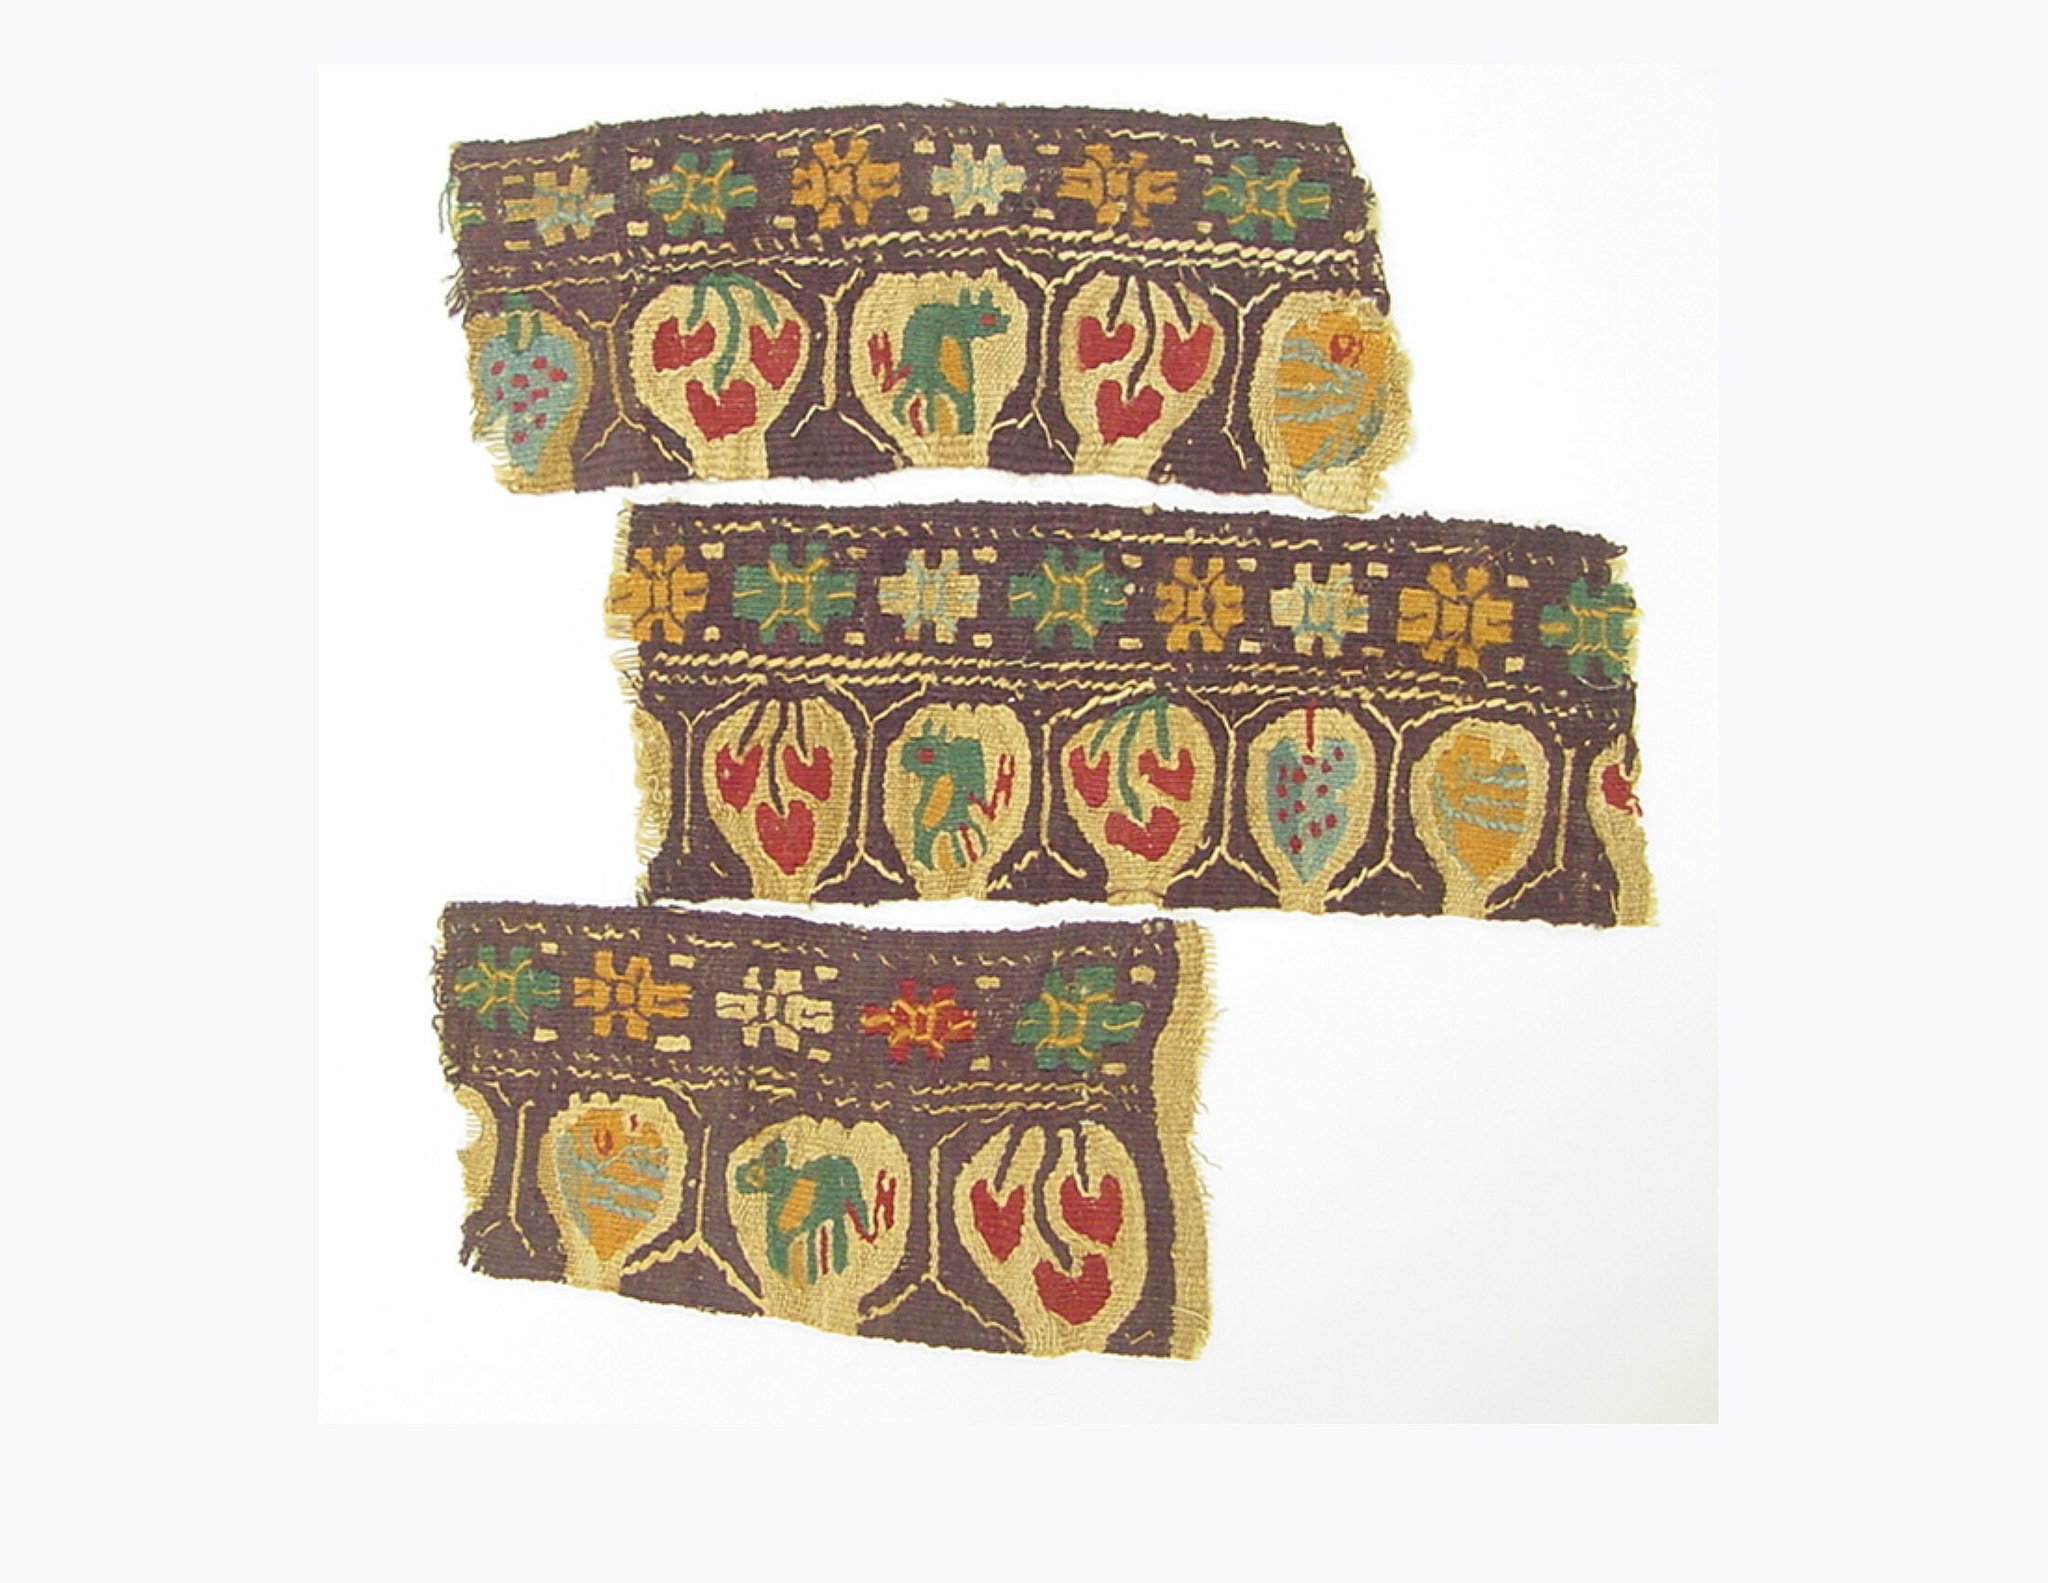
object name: textile fragment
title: Textile Fragments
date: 401-700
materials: linen, wool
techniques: weave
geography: egypt